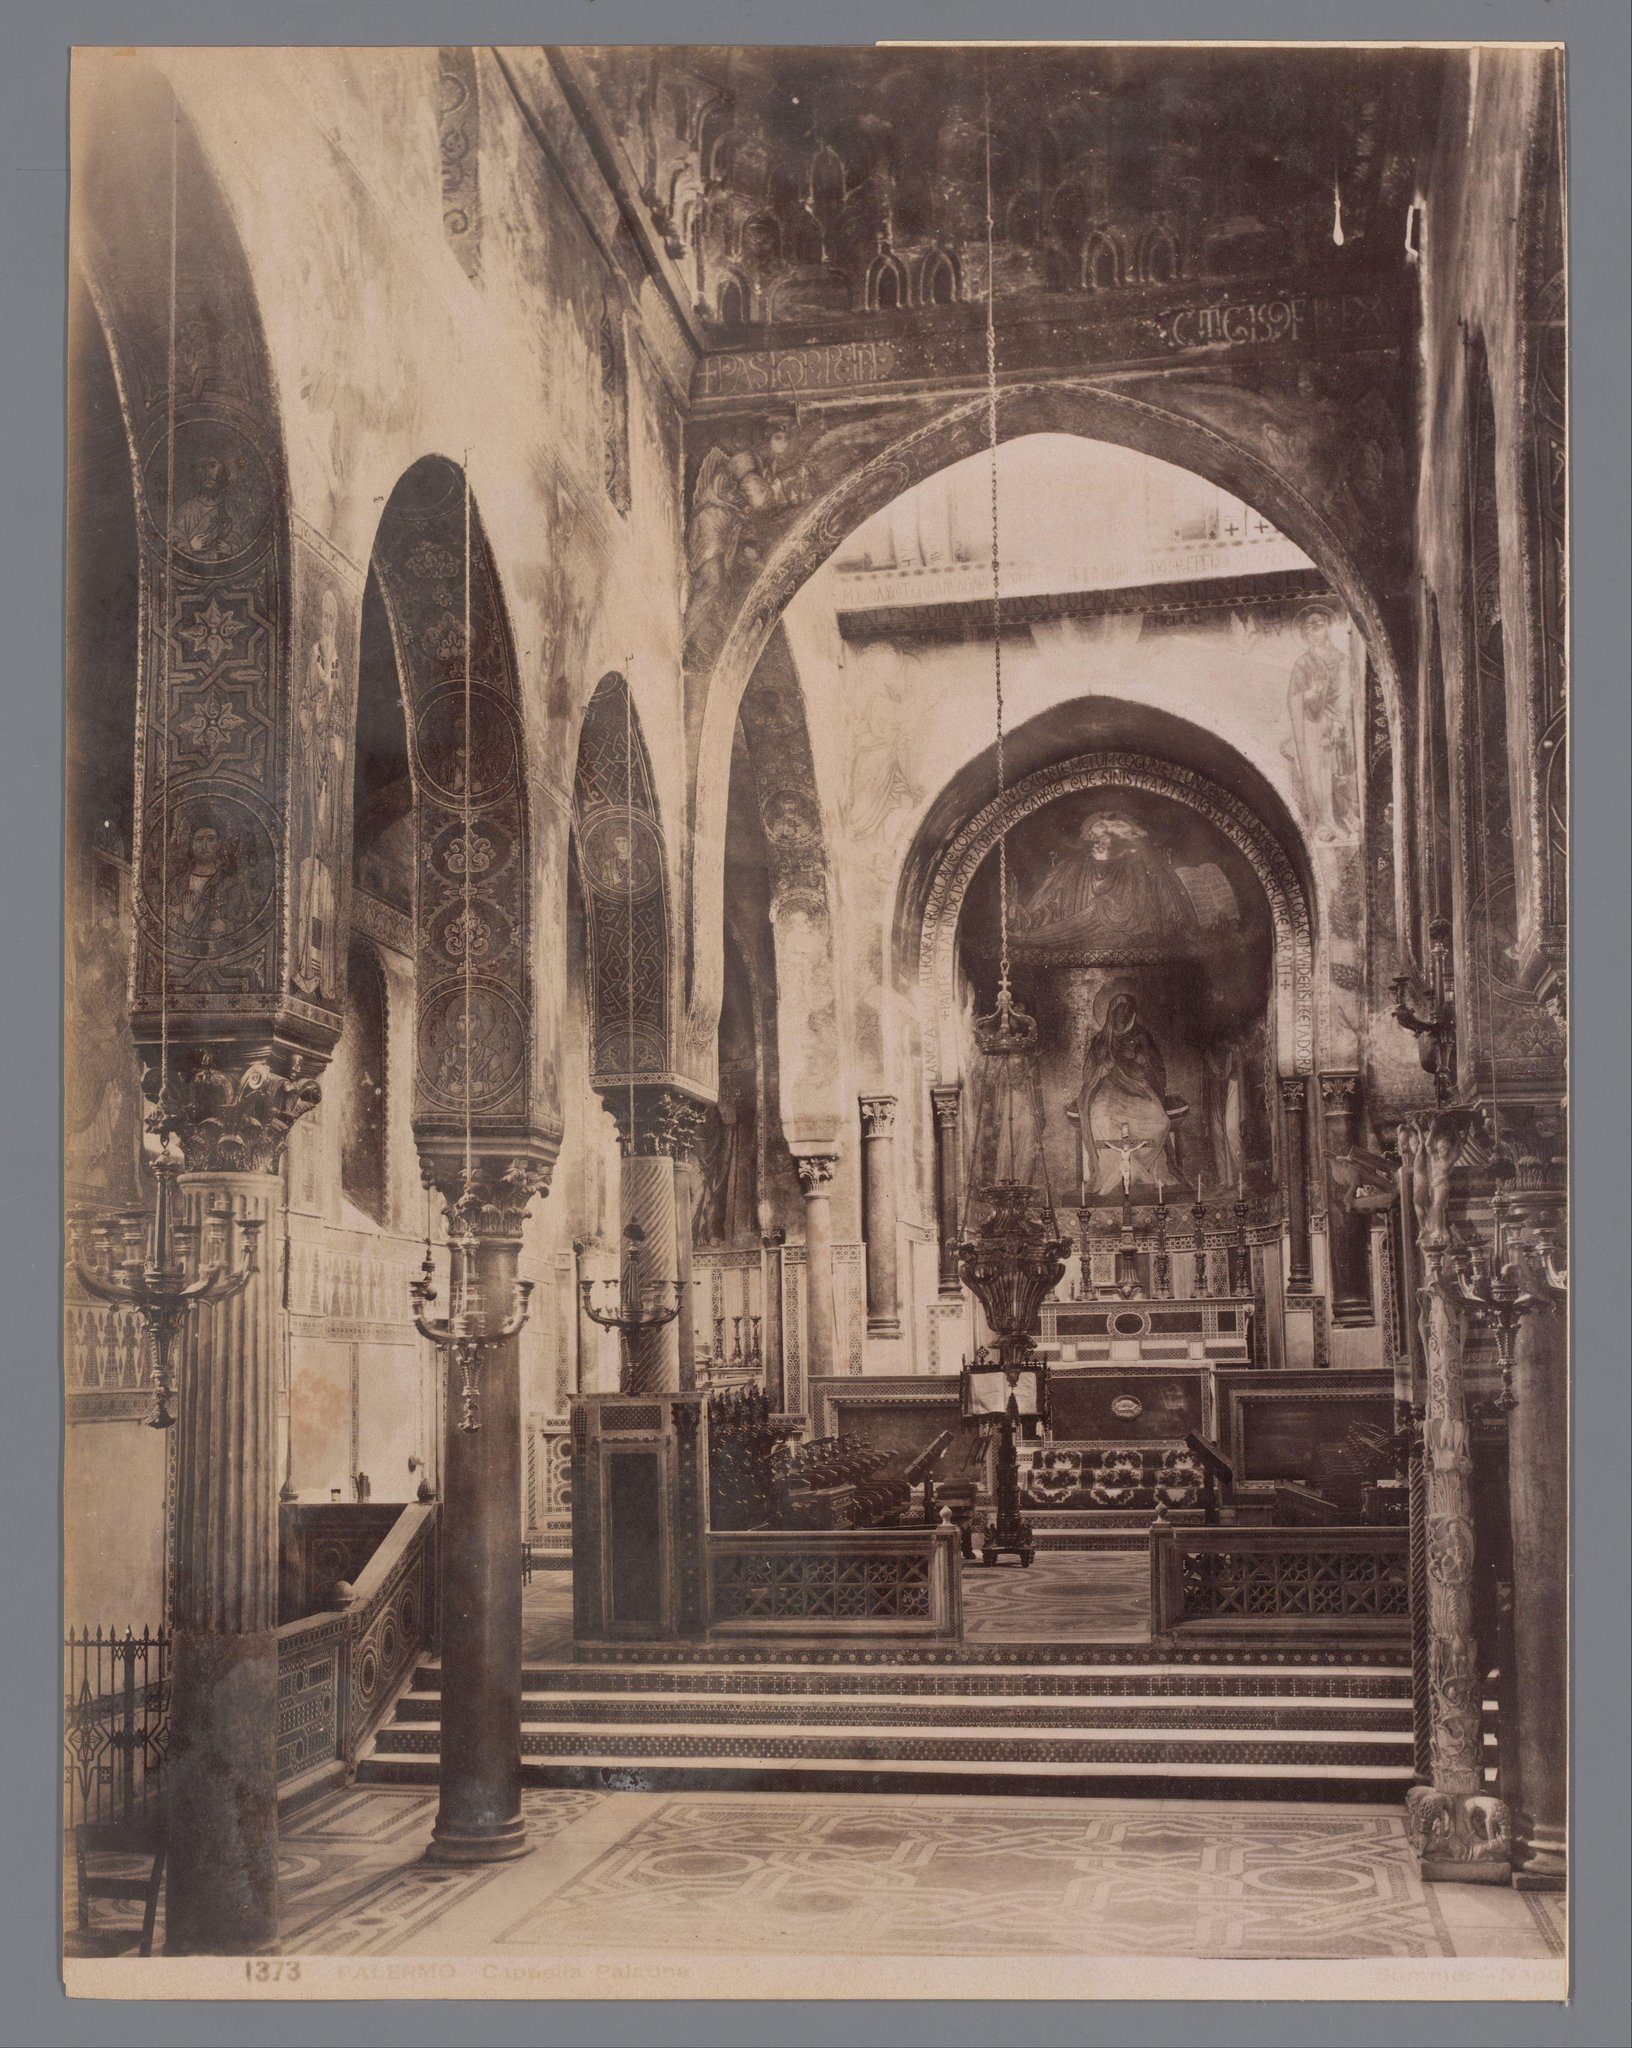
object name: photograph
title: Capella Palatine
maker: giorgio sommer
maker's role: fotograaf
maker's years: 1834-1914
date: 1857-1914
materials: paper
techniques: albumen print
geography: palermo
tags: parts of church interior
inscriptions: number: ‘1373’